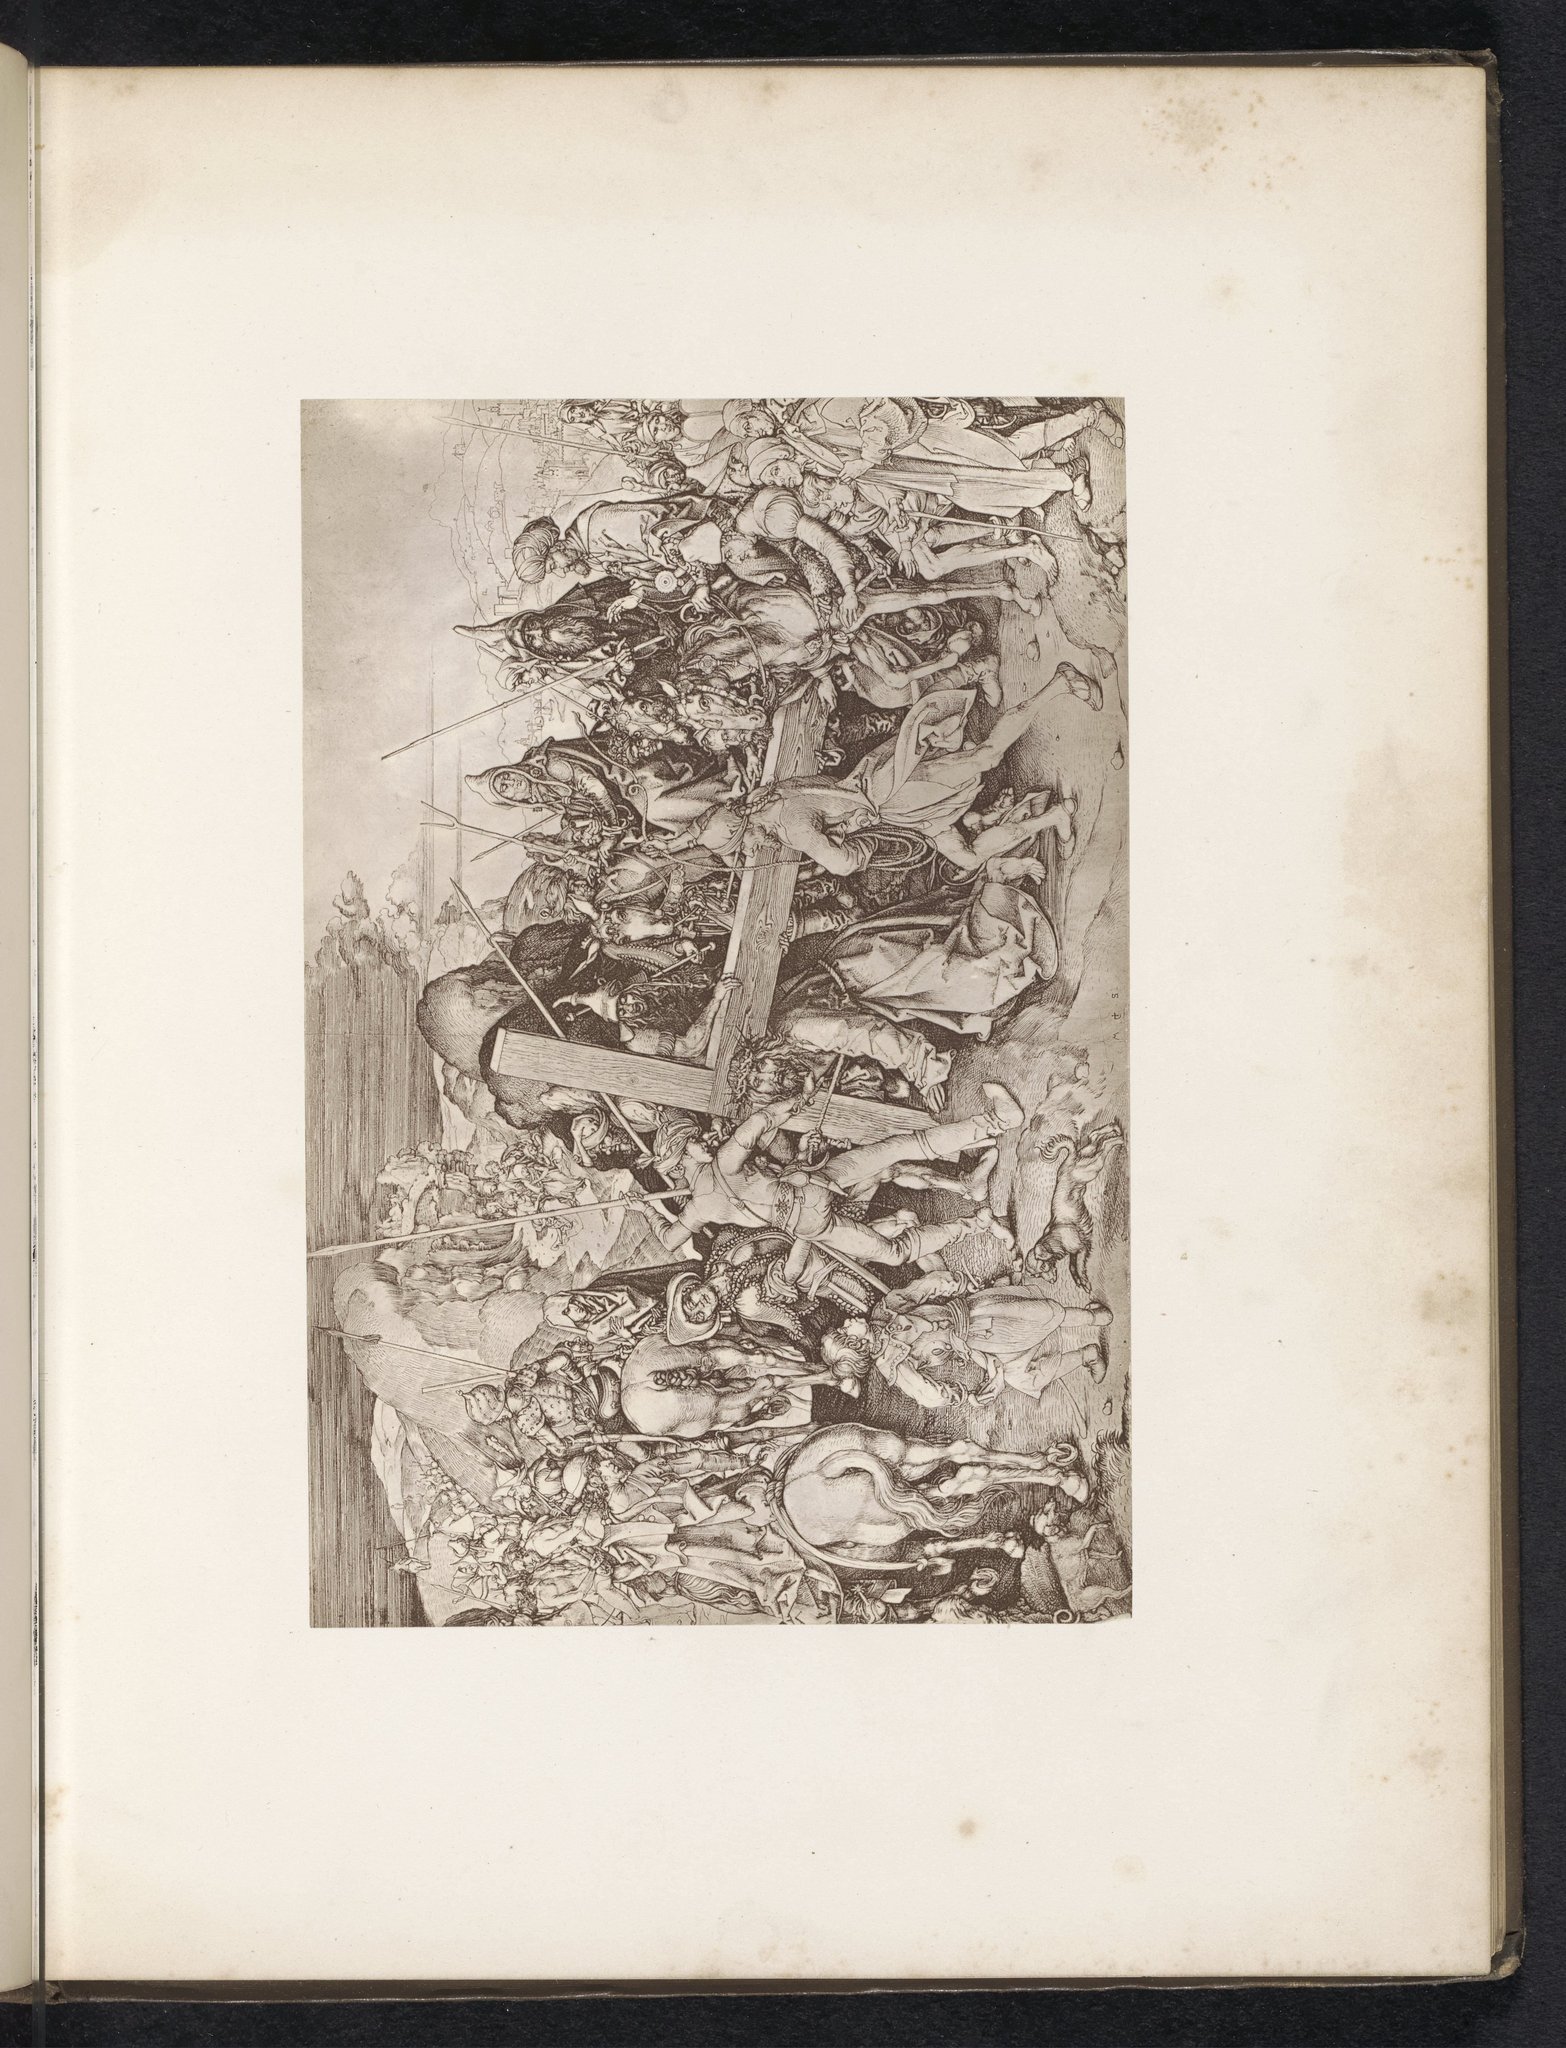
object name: reproduction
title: Fotoreproductie van een prent, voorstellende Christus draagt het kruis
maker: Anonymous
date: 1859-1869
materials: photographic support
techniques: albumen print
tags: christ collapsing ~ carrying of the cross